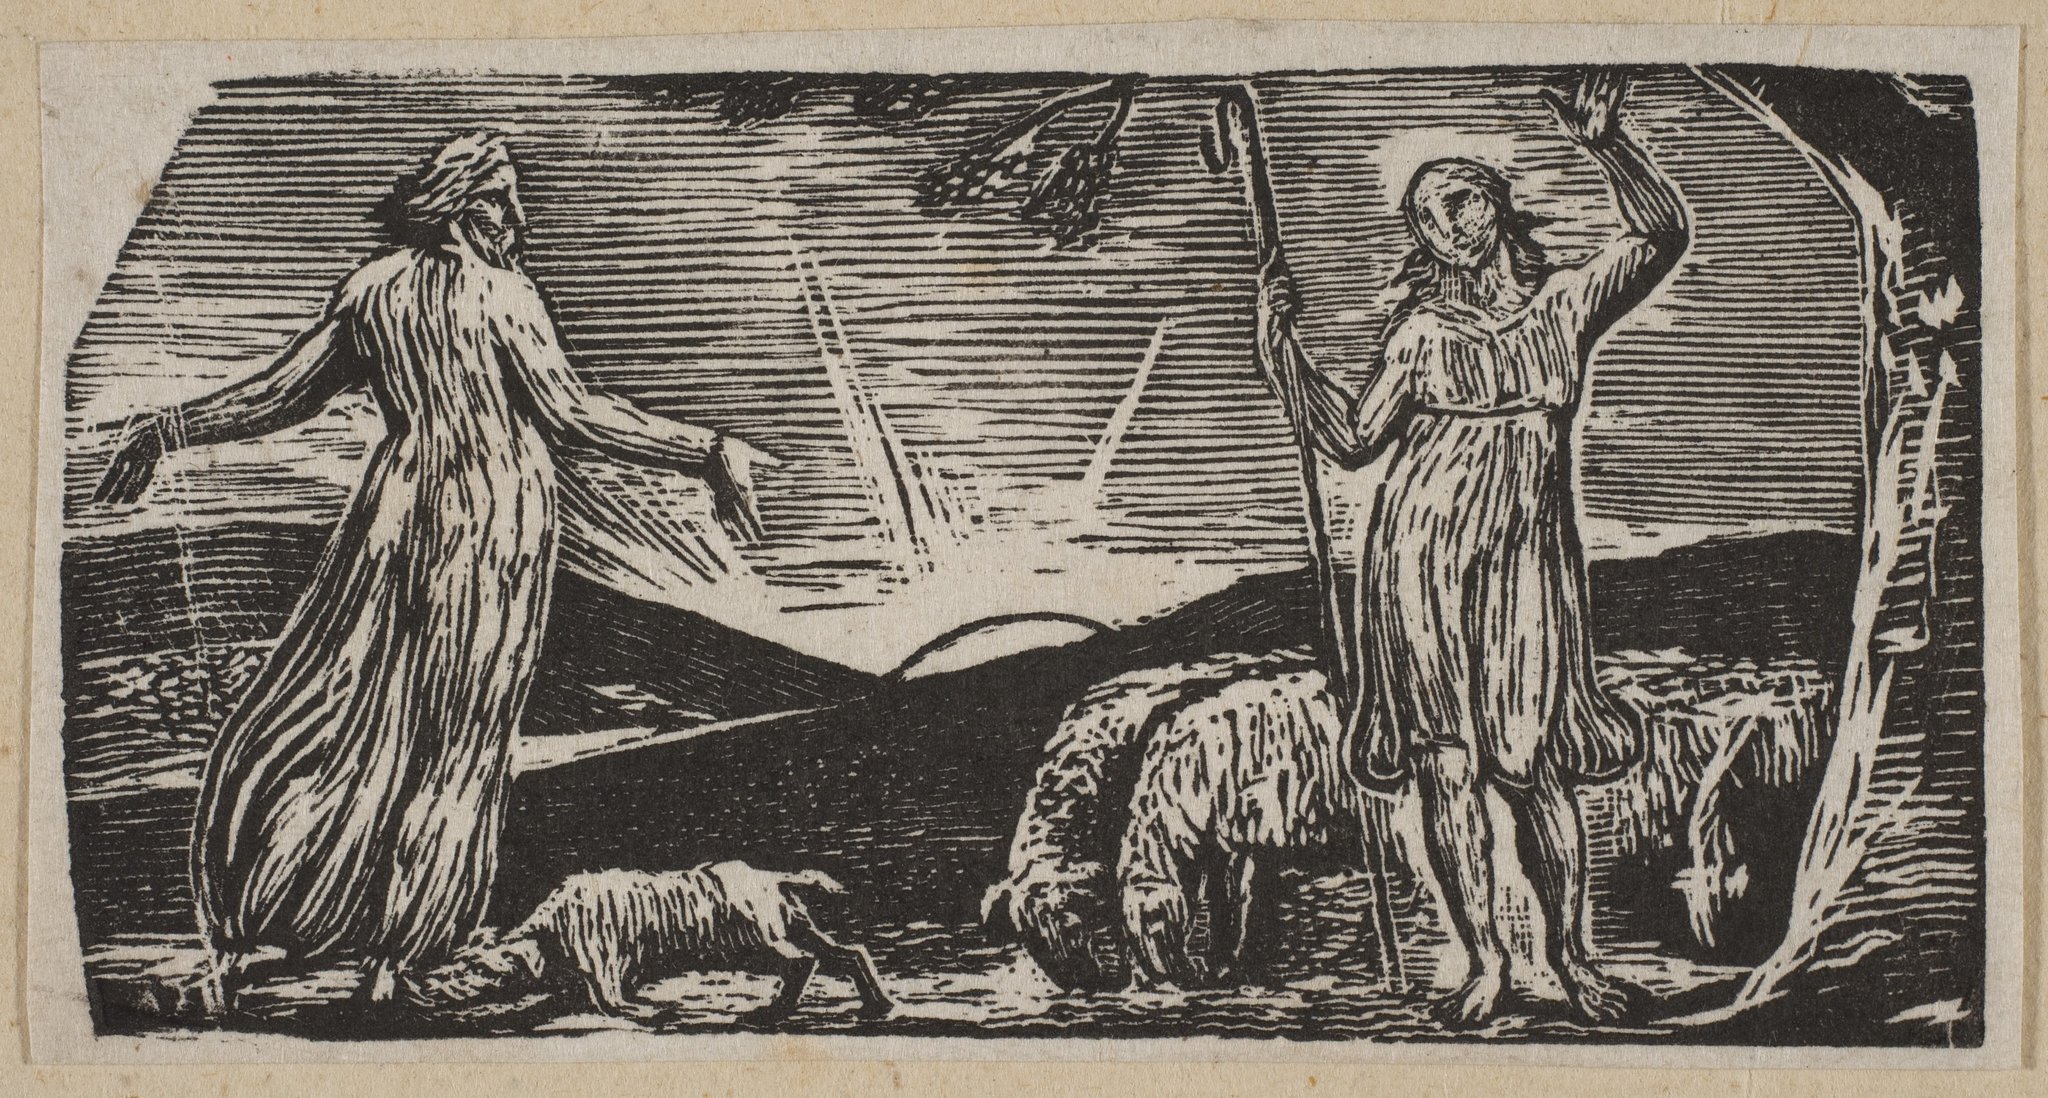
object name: print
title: Thenot Remonstrates With Colinet, from Thornton's "Pastorals of Virgil"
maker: william blake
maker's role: artist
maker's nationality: british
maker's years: 1757-1827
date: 1821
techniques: engraving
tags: animals,men,women